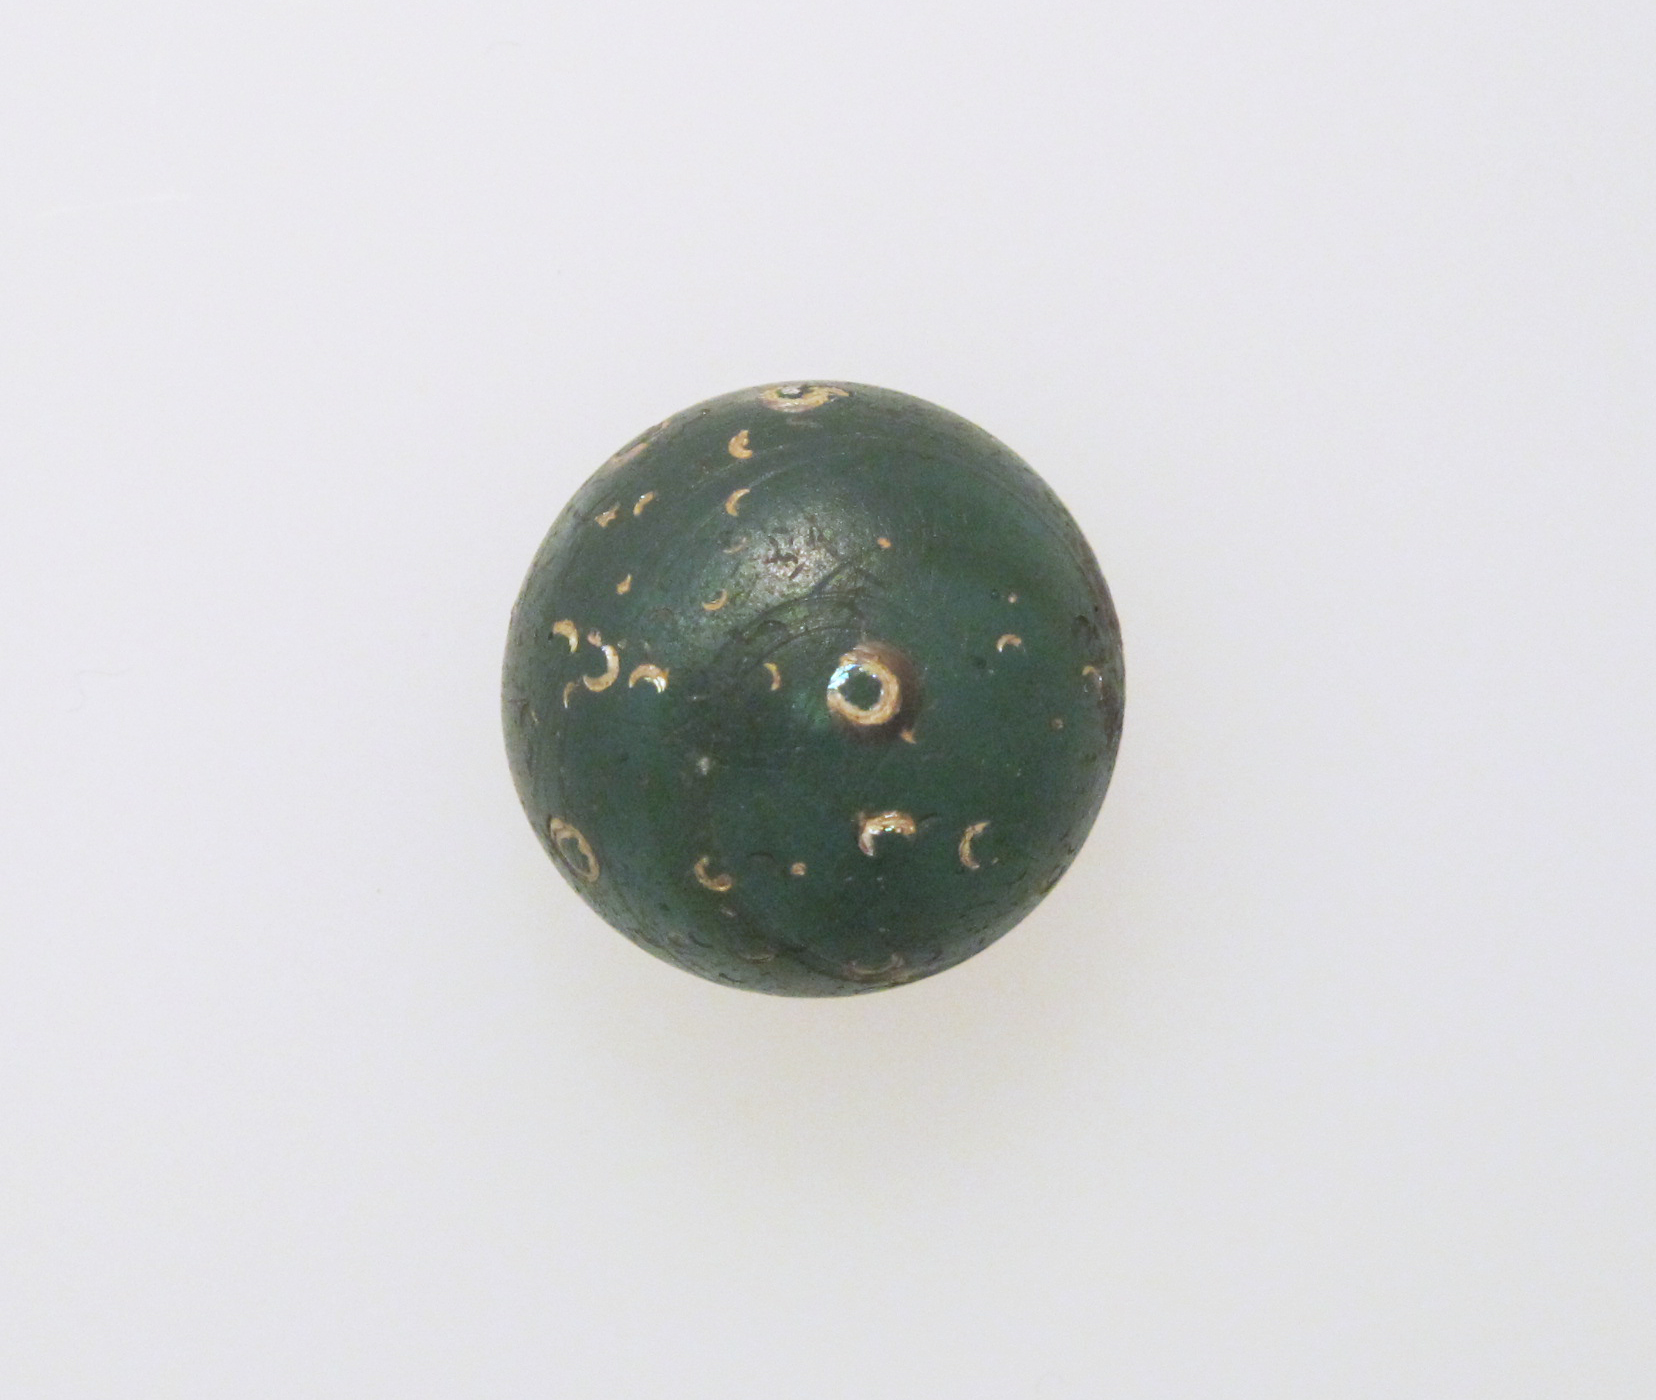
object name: pinhead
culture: roman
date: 670 BCE-330 CE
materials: glass